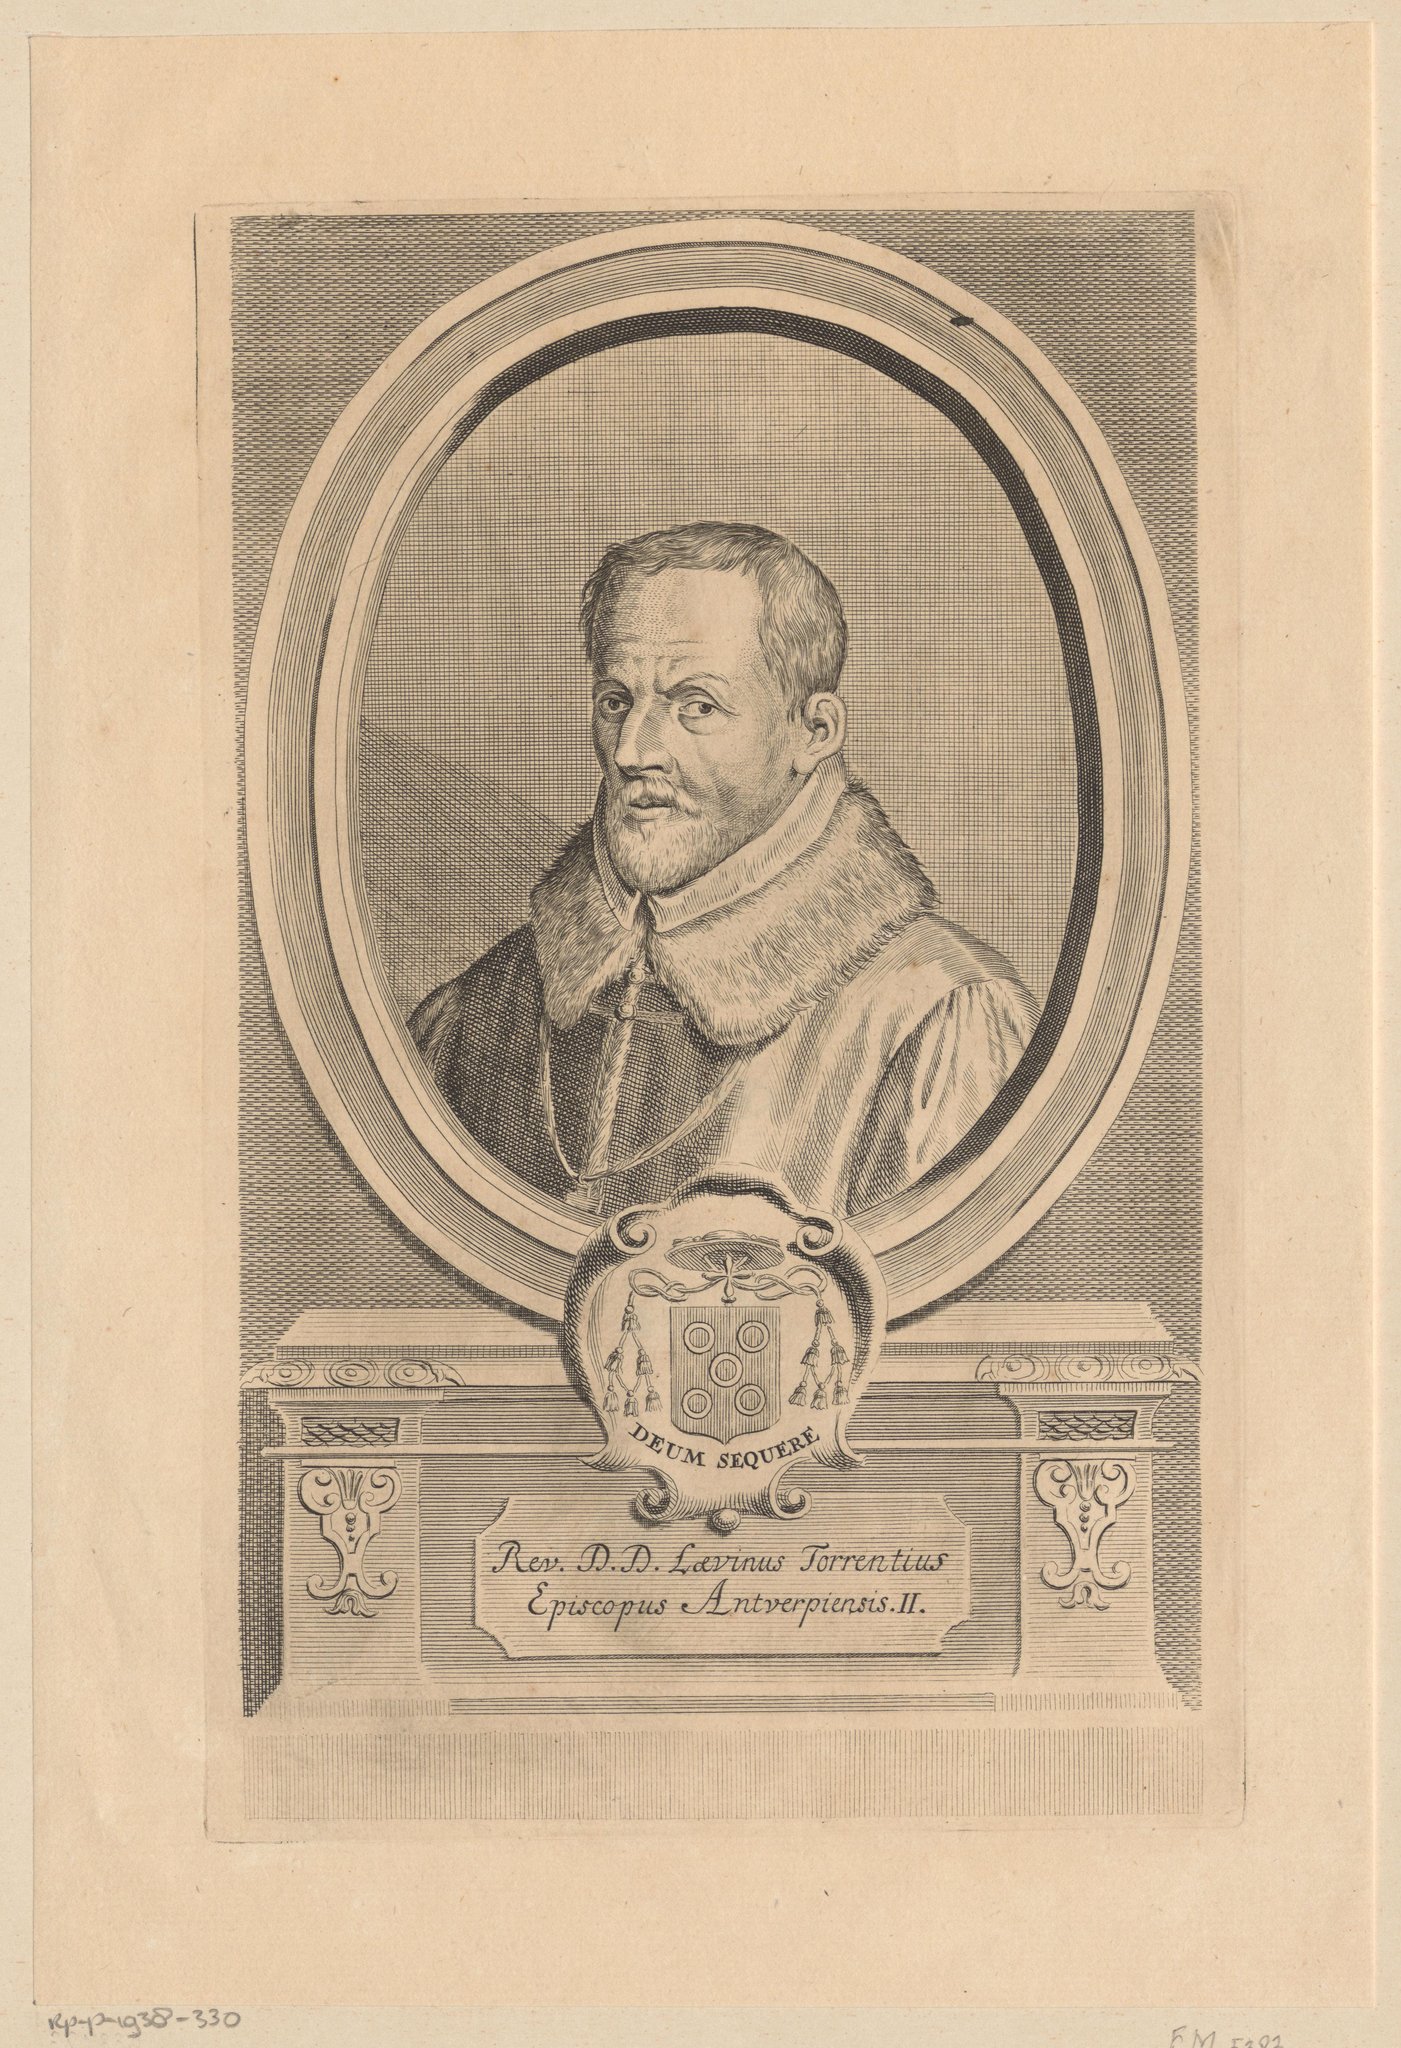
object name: print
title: Portret van Laevinus Torrentius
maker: jan baptist jongelinx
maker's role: print maker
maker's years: 1689-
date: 1727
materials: paper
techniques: engraving, etching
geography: antwerp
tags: ghent, brussels, laevinus torrentius, archbishop, bishop, etc. (roman catholic), historical persons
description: Prent waarschijnlijk uit: Le Roy, Jacuques. Groot kerkelyk toneel des hertogdoms van Brabant. Den Haag: Christiaan van Lom, 1727.